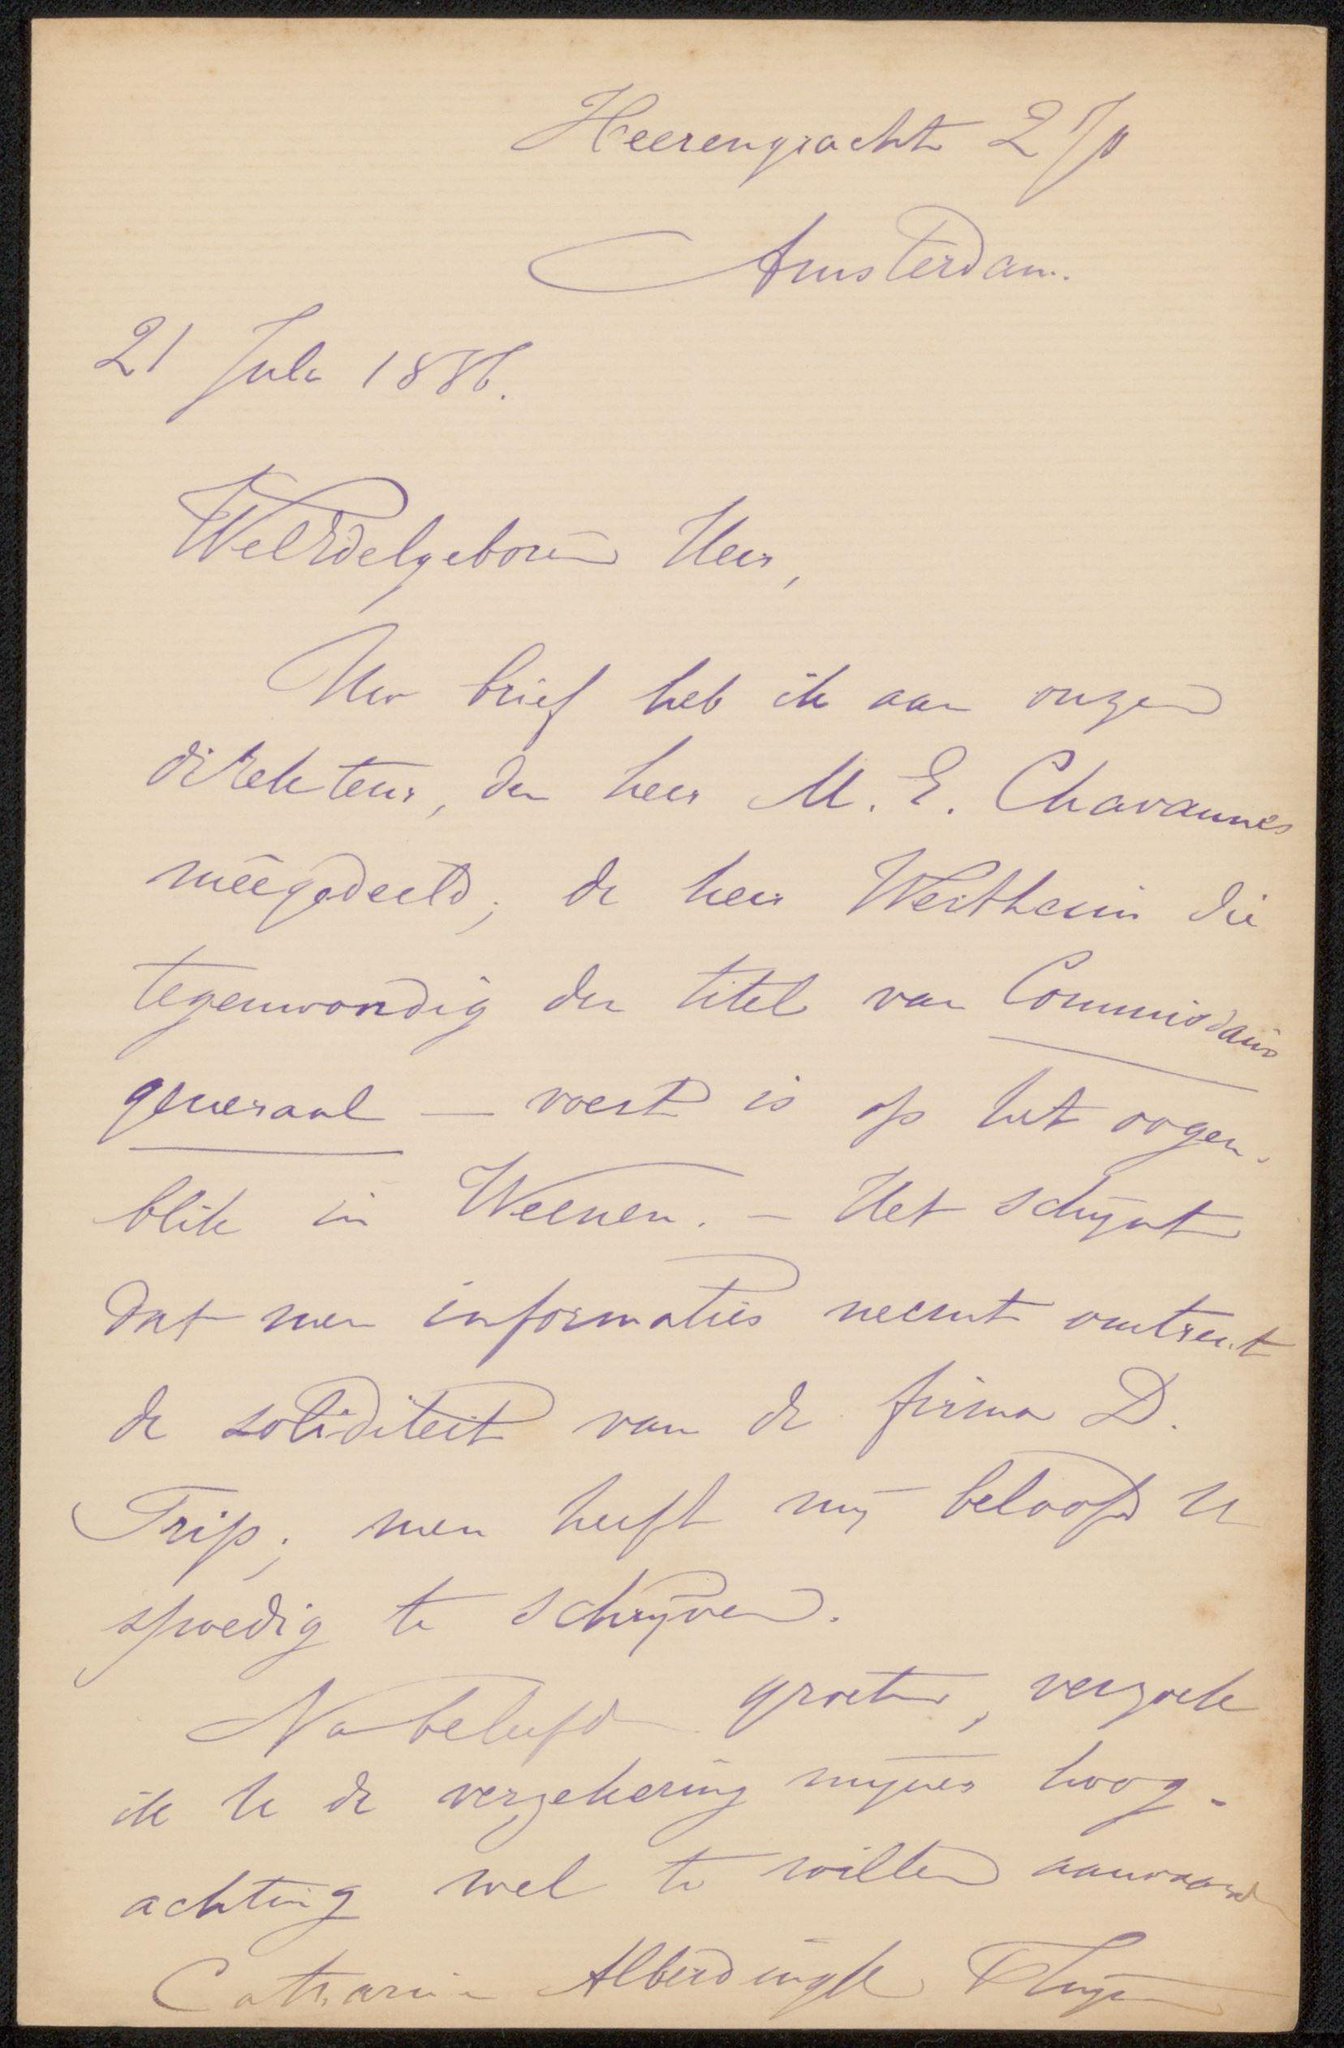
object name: letter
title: Brief aan Philip Zilcken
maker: catharina alberdingk thijm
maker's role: schrijver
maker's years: 1848-1908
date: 1886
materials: ink, paper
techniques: pen, writing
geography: amsterdam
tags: the hague, painter, draughtsman, philip zilcken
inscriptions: collector's mark: ‘RPK’